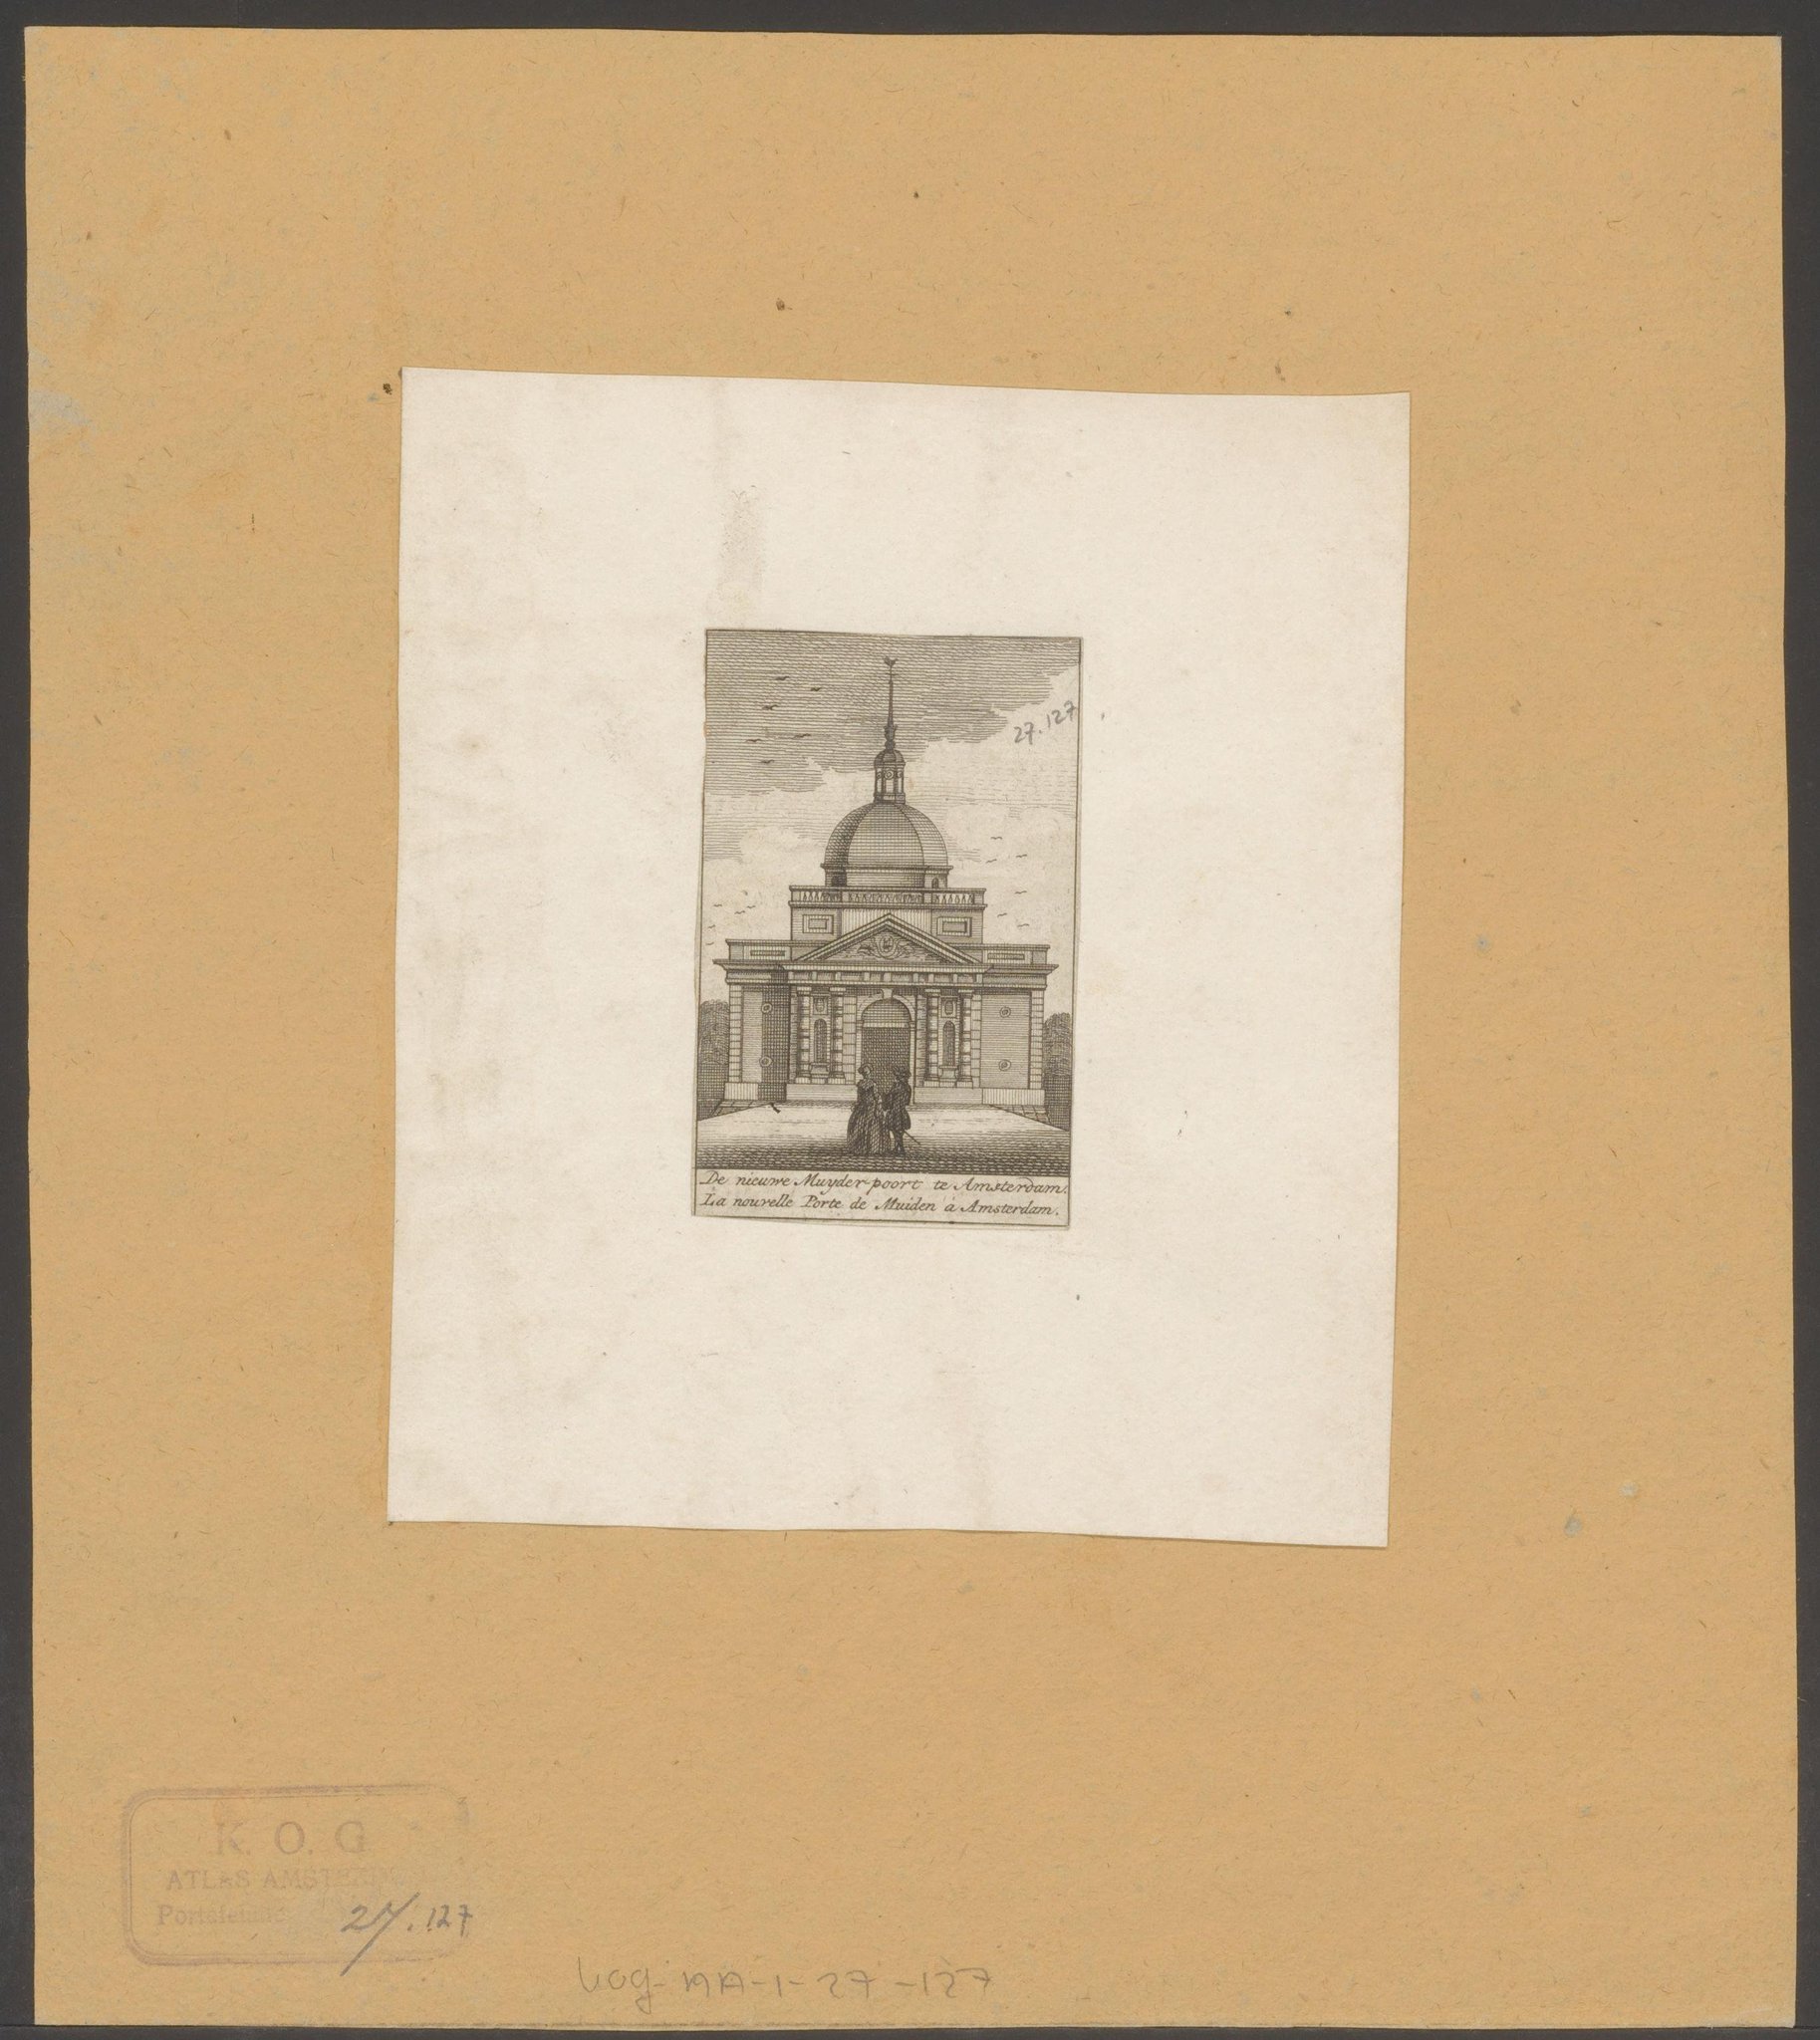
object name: book illustration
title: De nieuwe Muyder-poort te Amsterdam / La nouvelle Porte de Muiden à Amsterdam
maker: Anonymous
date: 1770-1849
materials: paper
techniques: engraving, etching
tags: city-gate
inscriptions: collector's mark: Lugt 1641b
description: Gezicht op de in 1770 gebouwde Tweede Muiderpoort. Onderwerpsrubriek binnen de Atlas Amsterdam: Poorten, verzamelbladen, J. Tweede Muiderpoort.